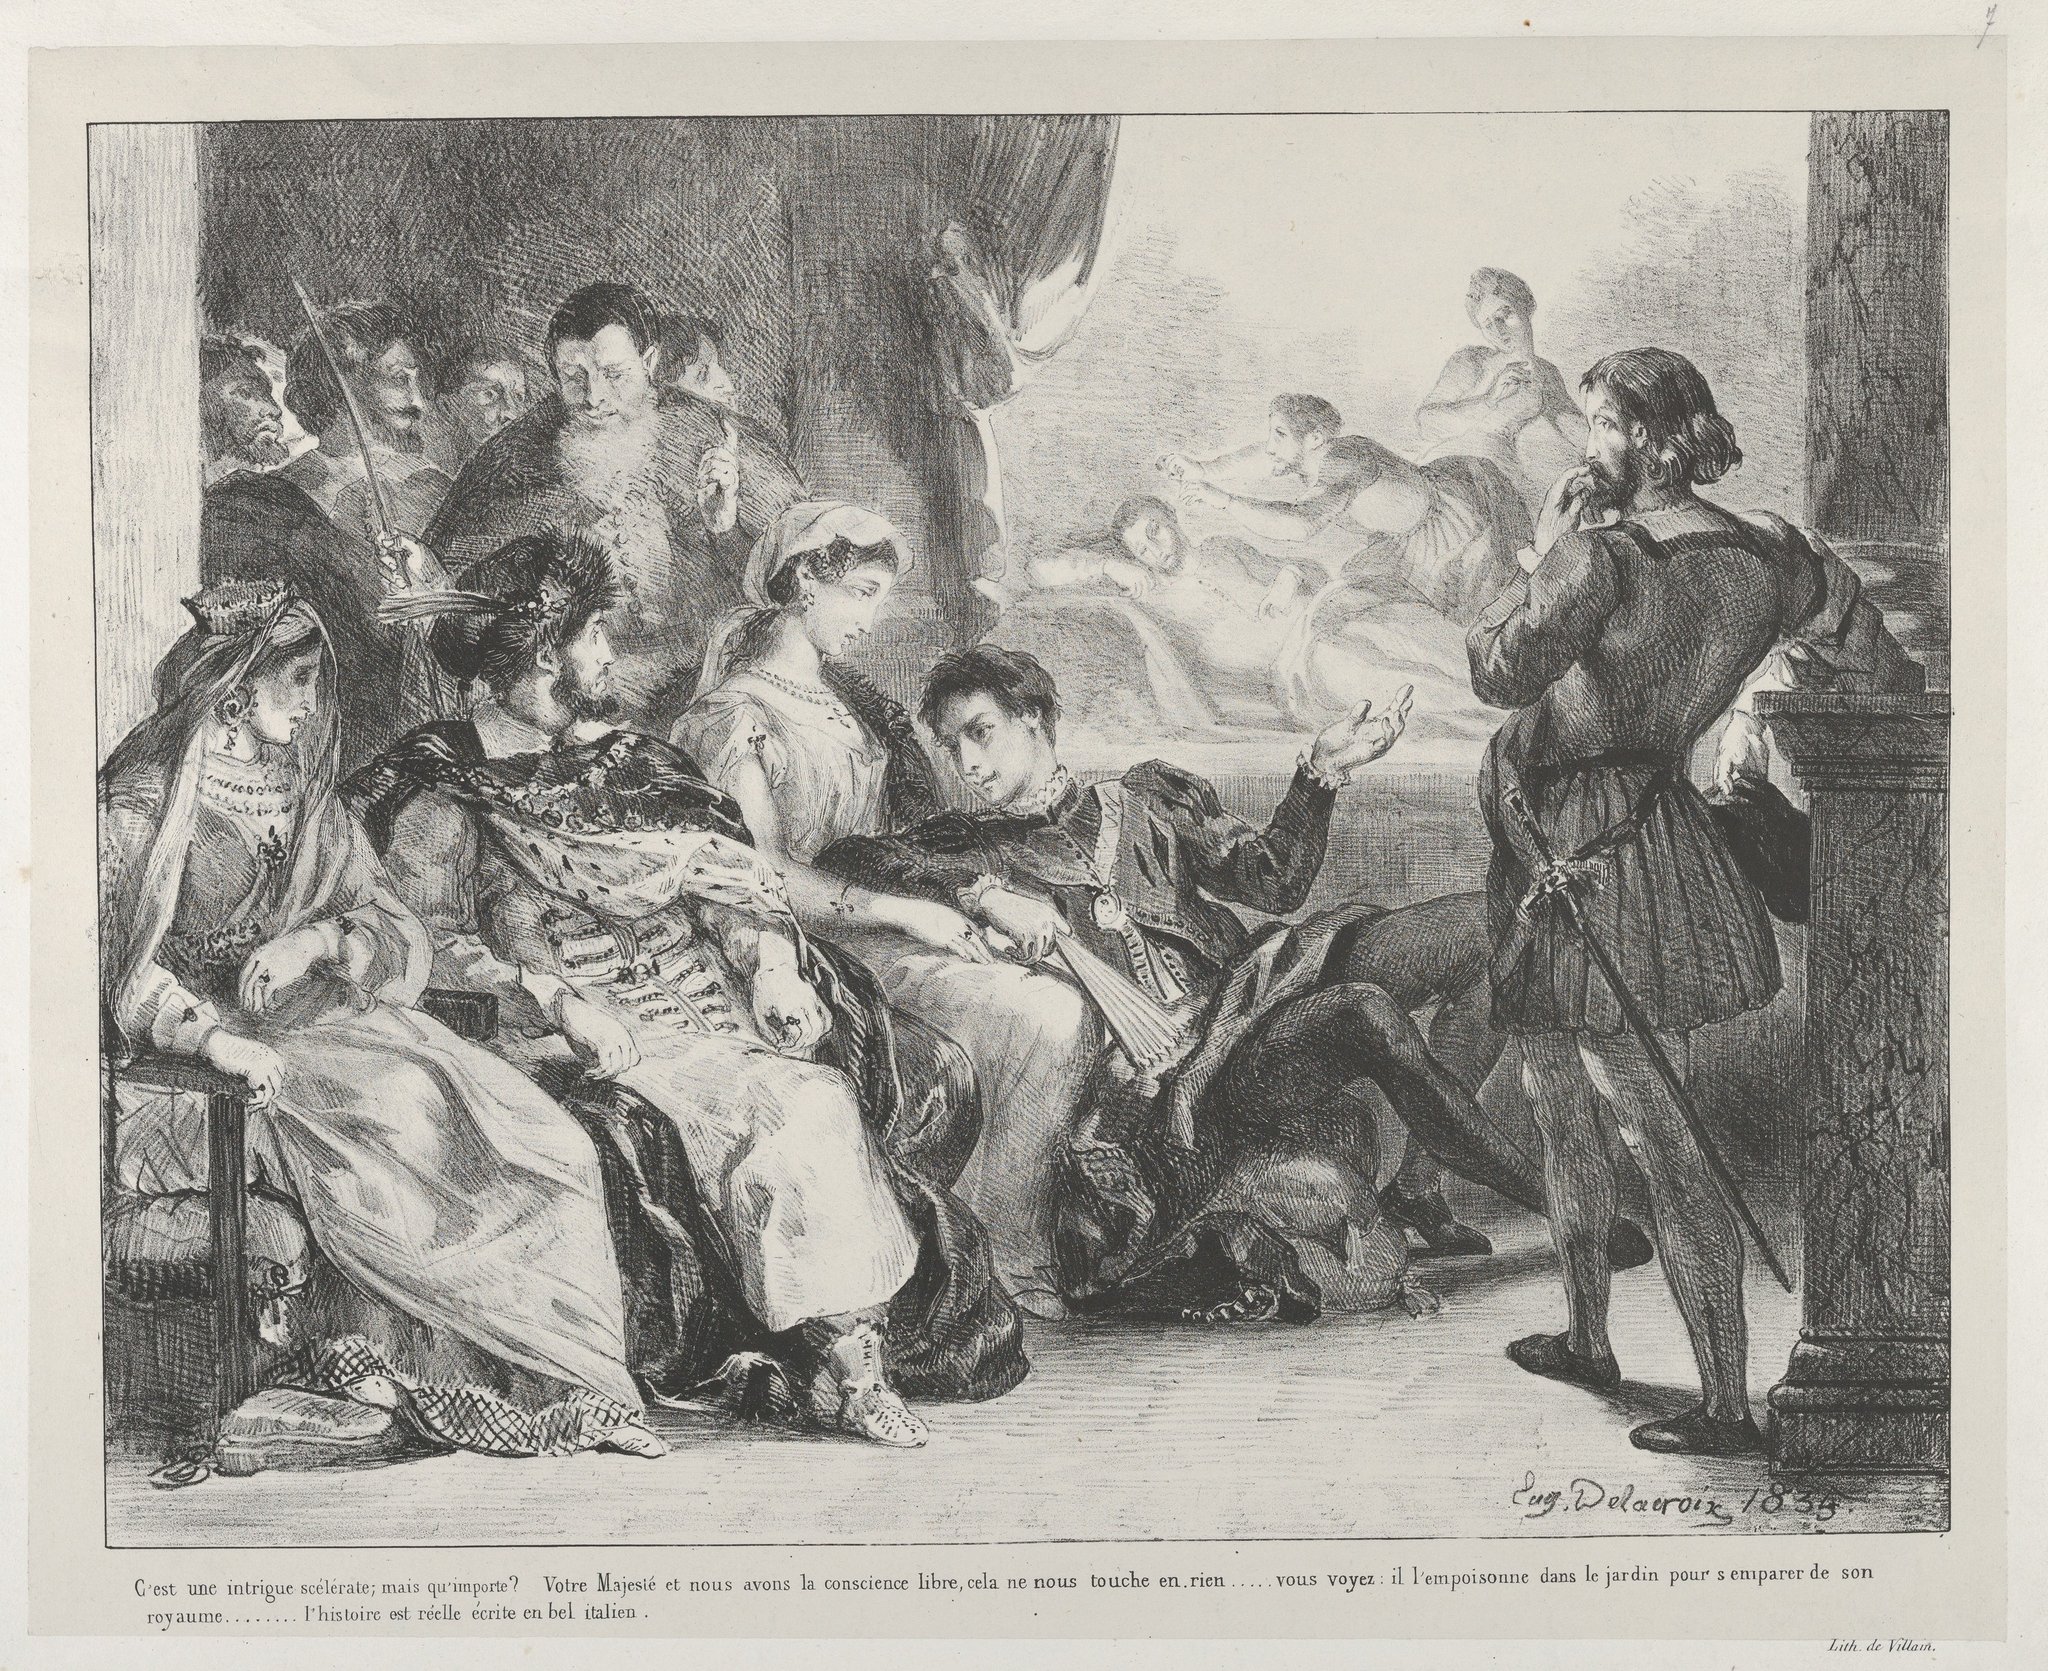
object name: print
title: The Play-Within-A-Play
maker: eugène delacroix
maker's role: artist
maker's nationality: french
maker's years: 1798-1863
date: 1835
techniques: lithograph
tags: shakespeare,men,women,hamlet